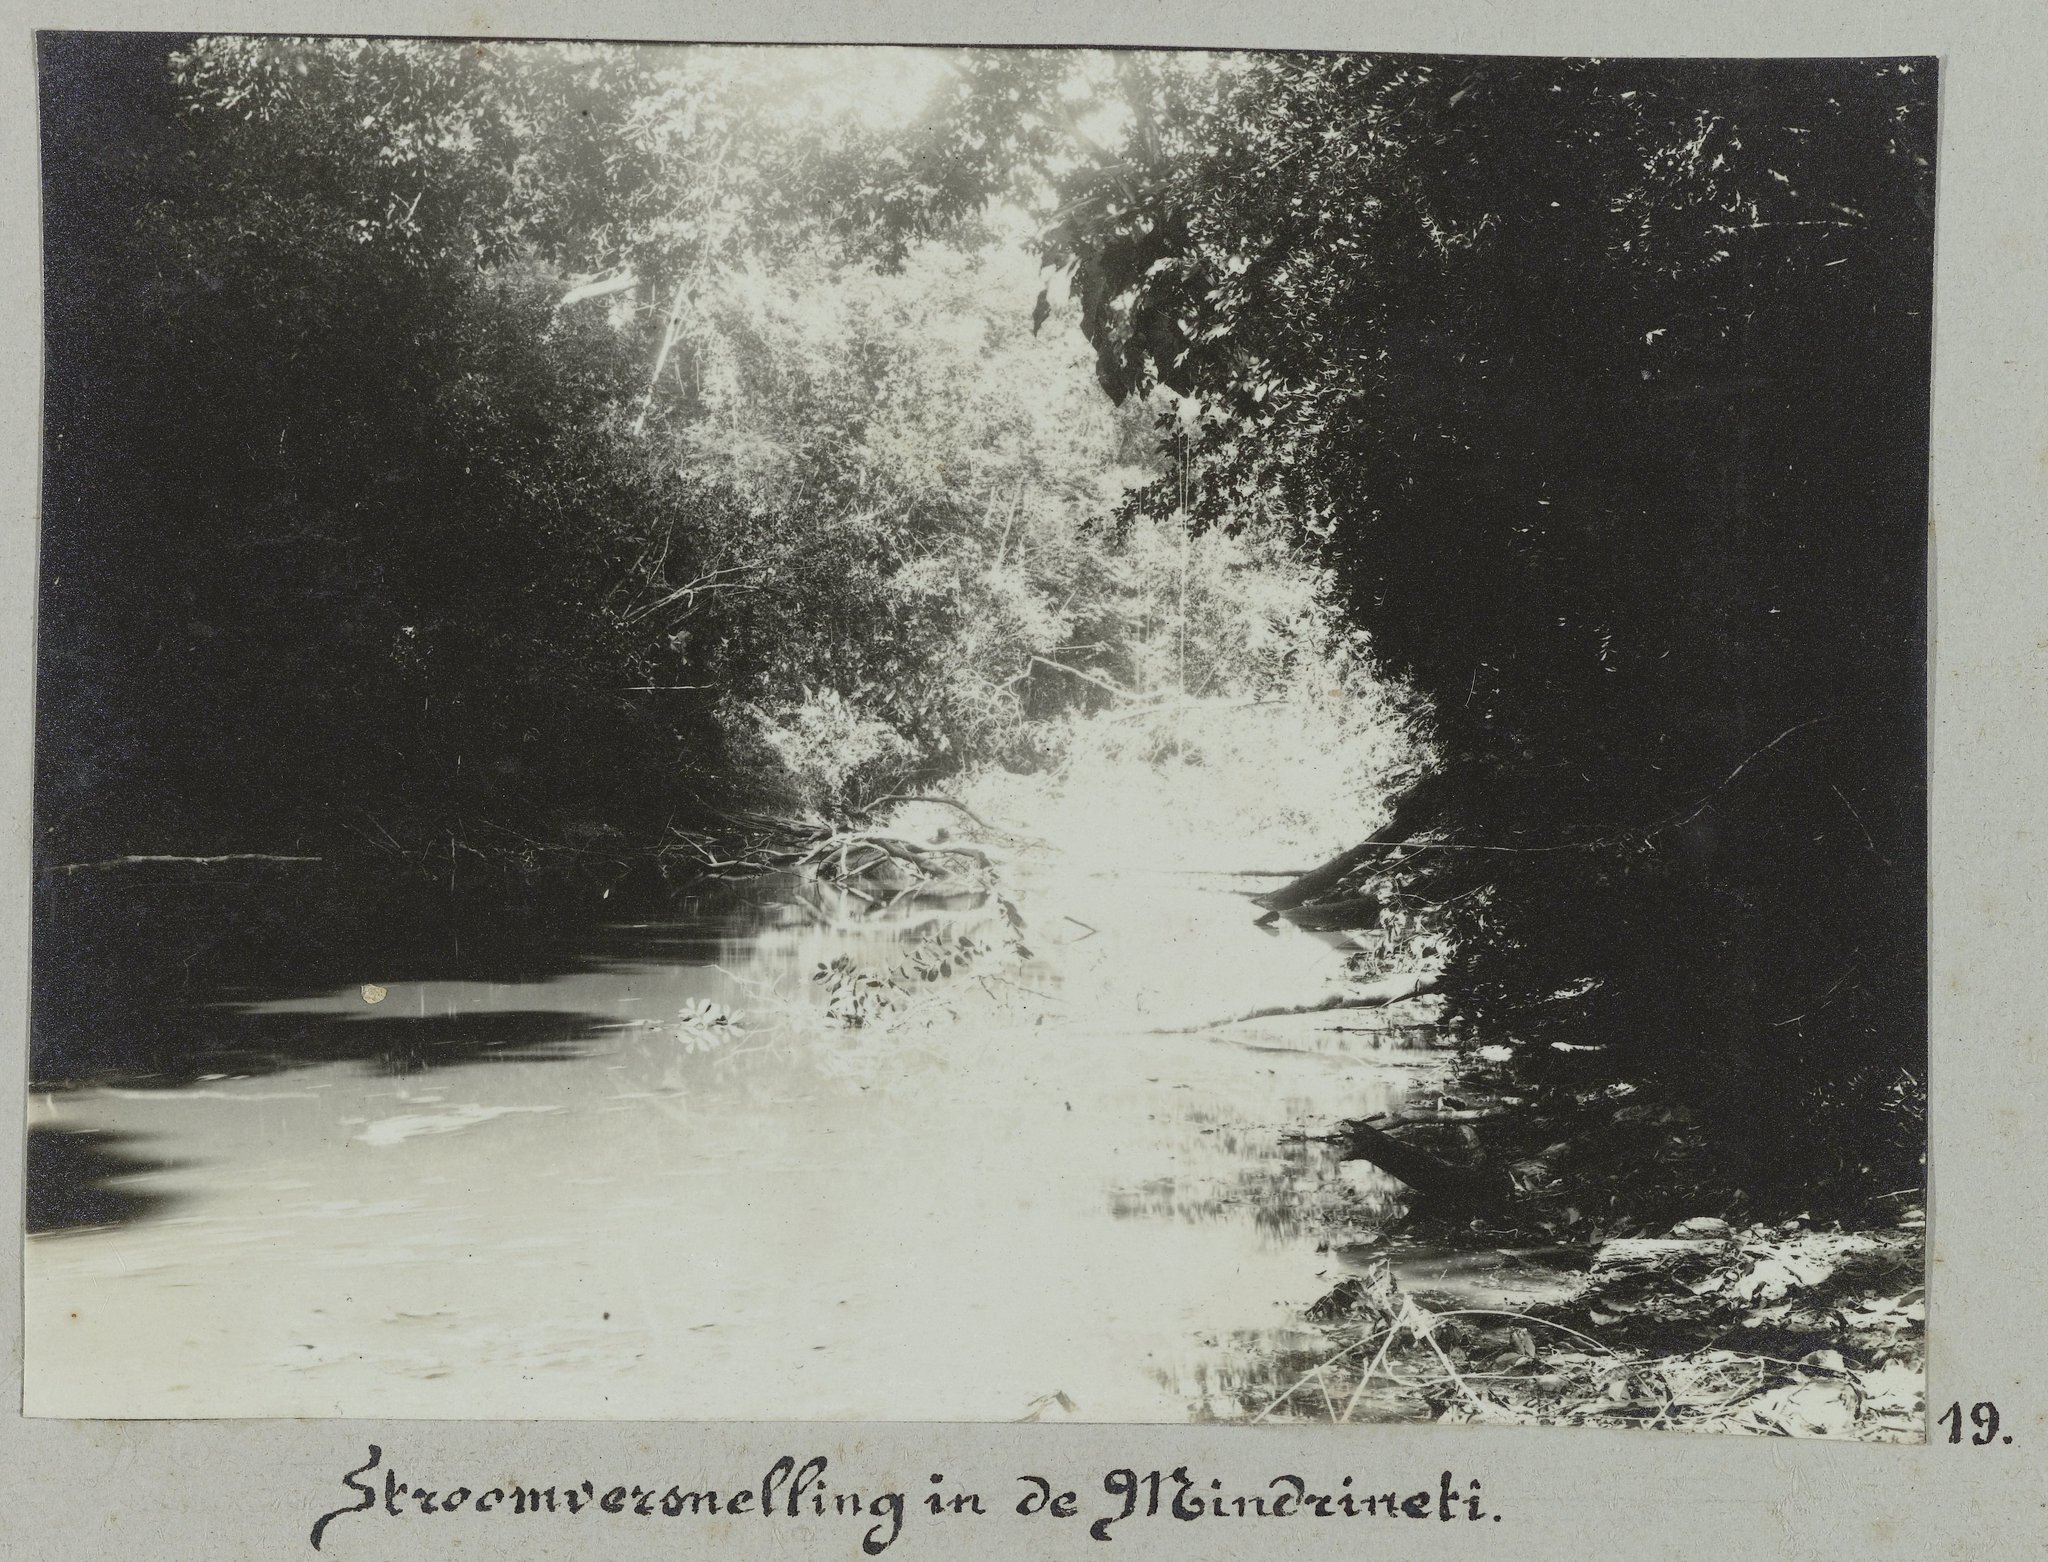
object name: photograph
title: Stroomversnelling in de Mindrineti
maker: hendrik doijer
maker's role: engineer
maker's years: 1863-1925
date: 1903-1910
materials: photographic support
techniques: gelatin silver print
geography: suriname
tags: suriname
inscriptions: inscription: ‘19. / Stroomversnelling in de Mindrineti.’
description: Stroomversnelling in de Miendrieneti Kreek. Onderdeel van het fotoalbum Souvenir de Voyage (deel 1), over het leven van de familie Doijer in en rond de plantage Ma Retraite in Suriname in de jaren 1903-1910.